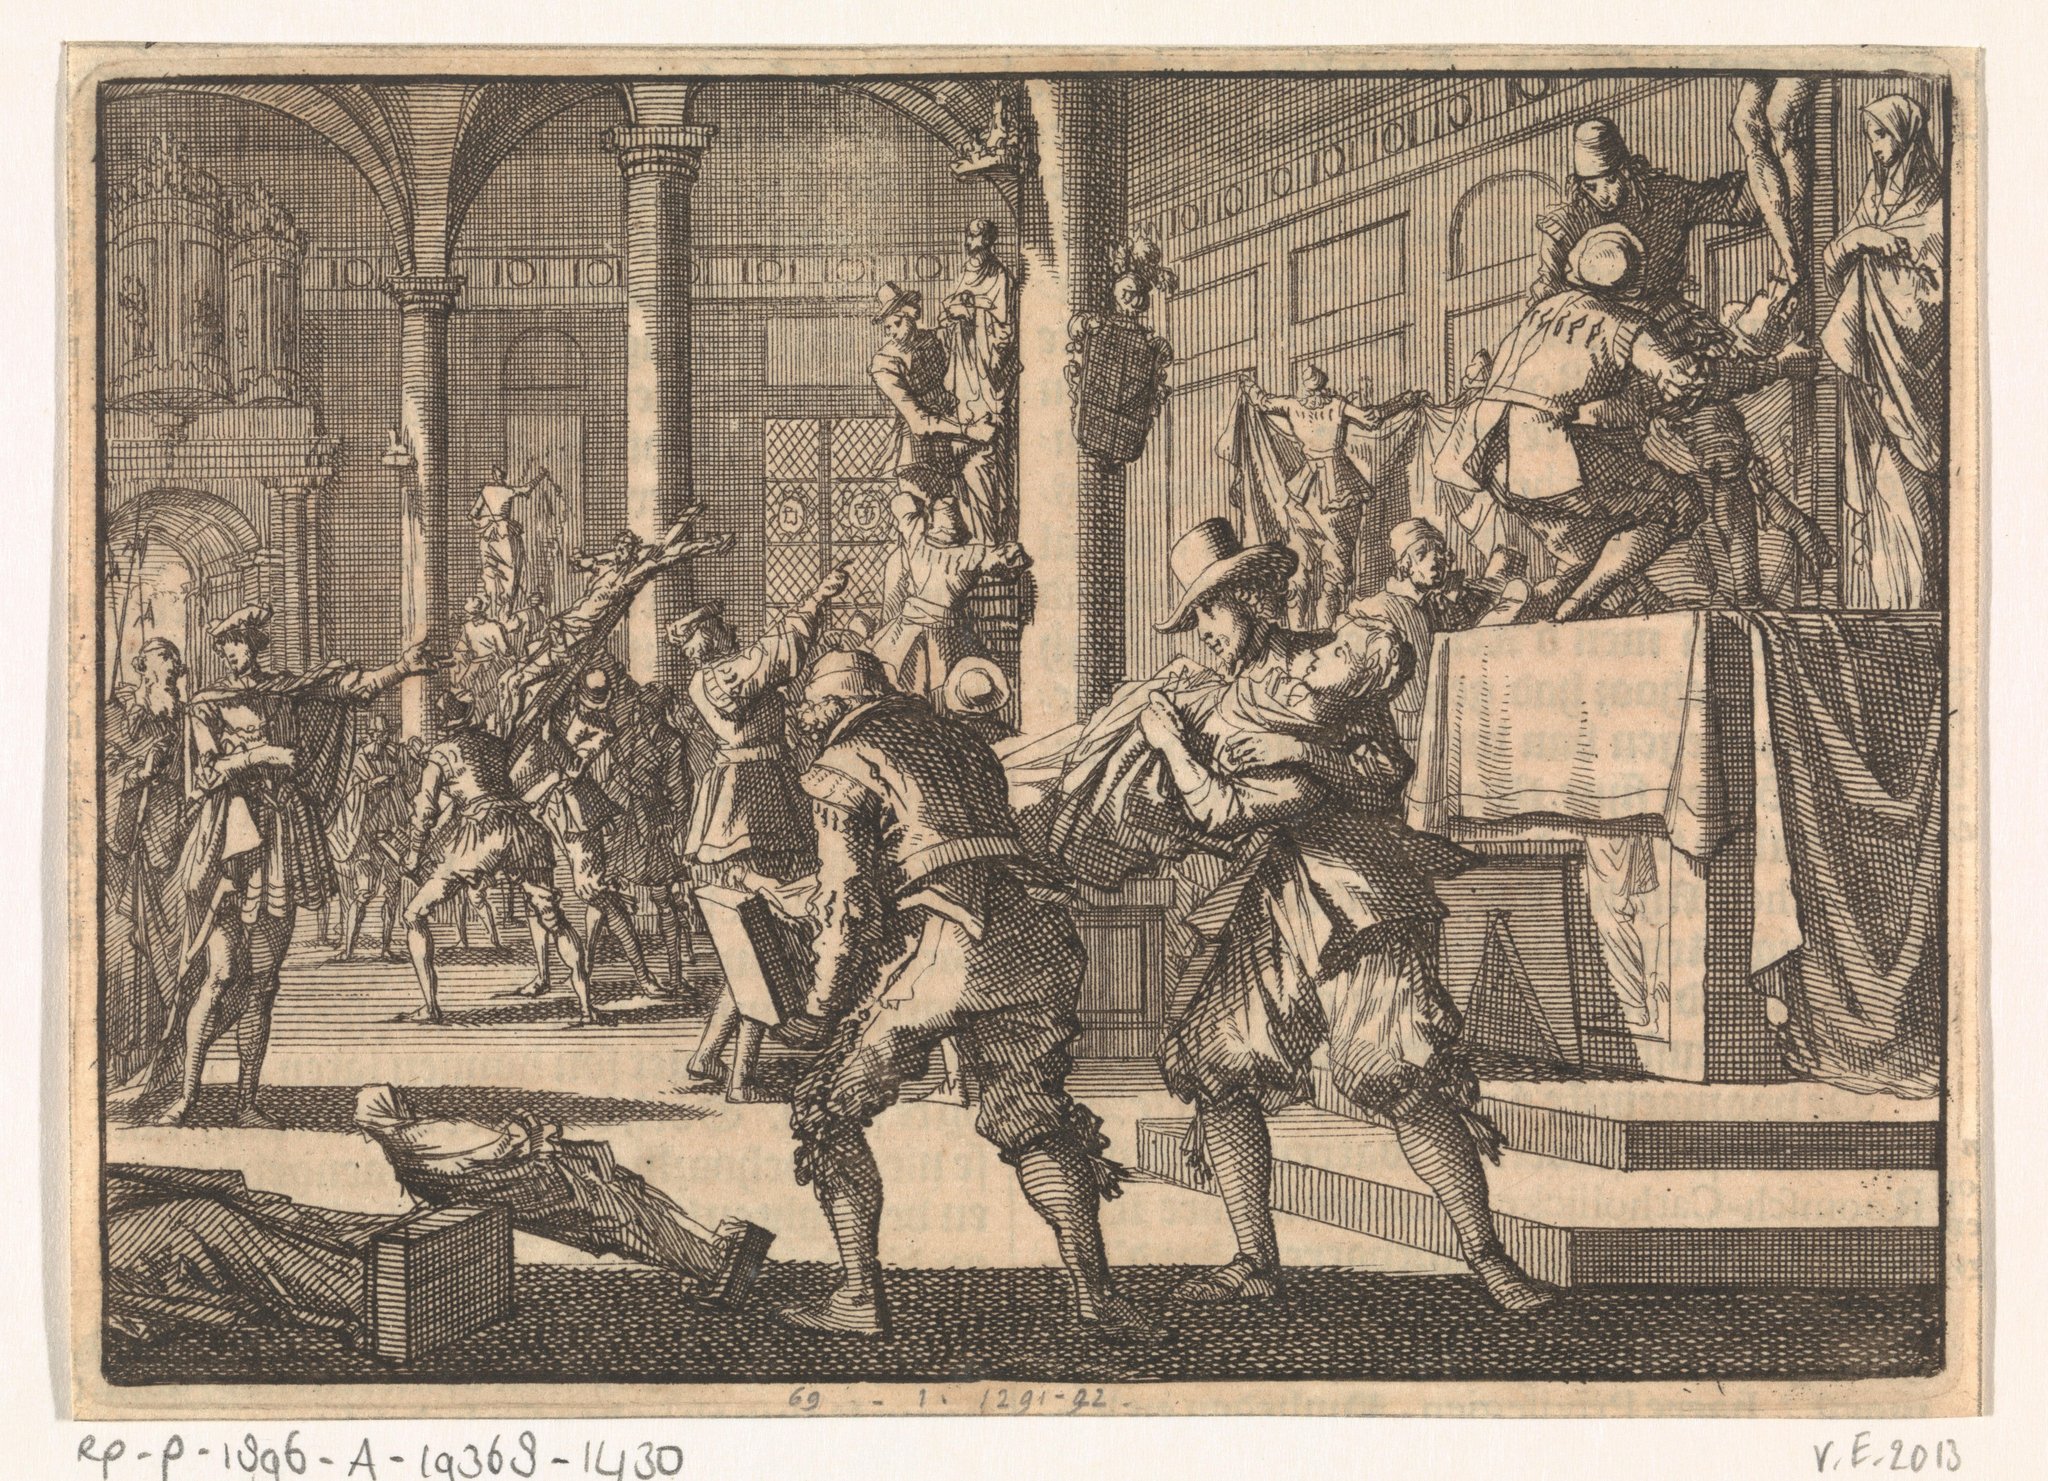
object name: print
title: Koning Frederik van Bohemen laat de beelden uit de Slotkerk te Praag verwijderen, 1619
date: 1698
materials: paper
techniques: etching, letterpress printing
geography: amsterdam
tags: frederik v (keurvorst van de palts, koning van bohemen), interior of church, sculpture, prague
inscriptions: collector's mark: Lugt 2228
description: Illustratie uit: Gottfried, Johann Ludwig. Historische kronyck; vervattende een (...) beschrijvingh der aldergedenckwaerdigste geschiedenissen des weerelds, van den aenvangh der scheppingh tot (...) 1576 (2 delen). Leiden: Pieter van der Aa, 1698, dl. I, p. 1291.